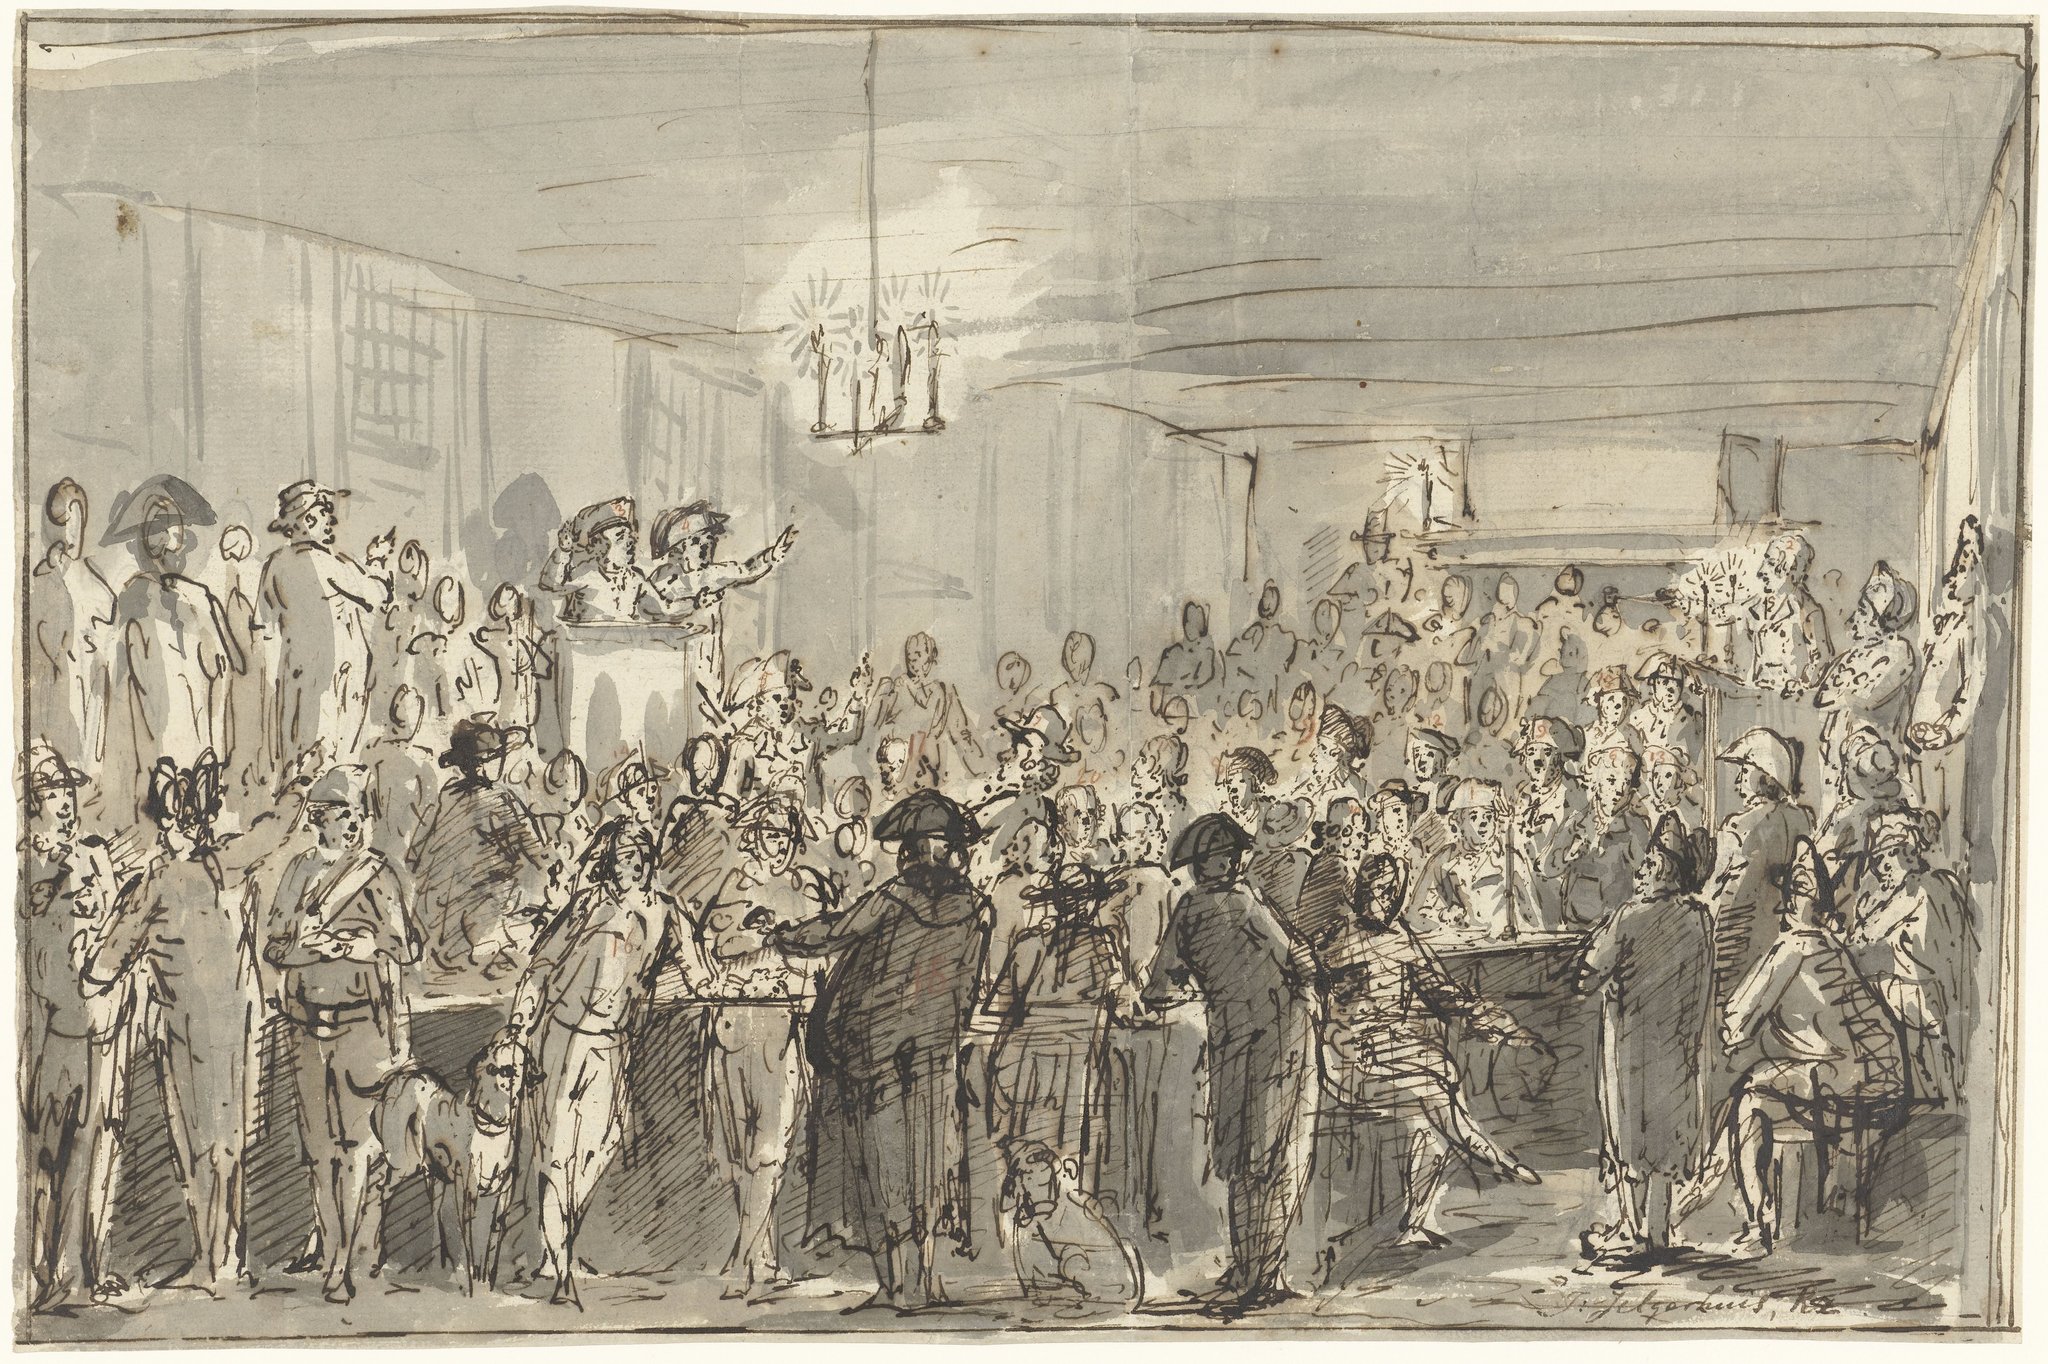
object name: drawing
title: Een revolutionaire vergadering te Delft in 1795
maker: johannes jelgerhuis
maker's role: draughtsman, painter, print maker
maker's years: 1770-1836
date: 1795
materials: chalk, paper, pencil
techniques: brush, pen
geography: netherlands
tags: political meeting, propaganda meeting, historical events and situations, delft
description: Niet in Frederik Muller; door het RPK toegevoegd nummer.